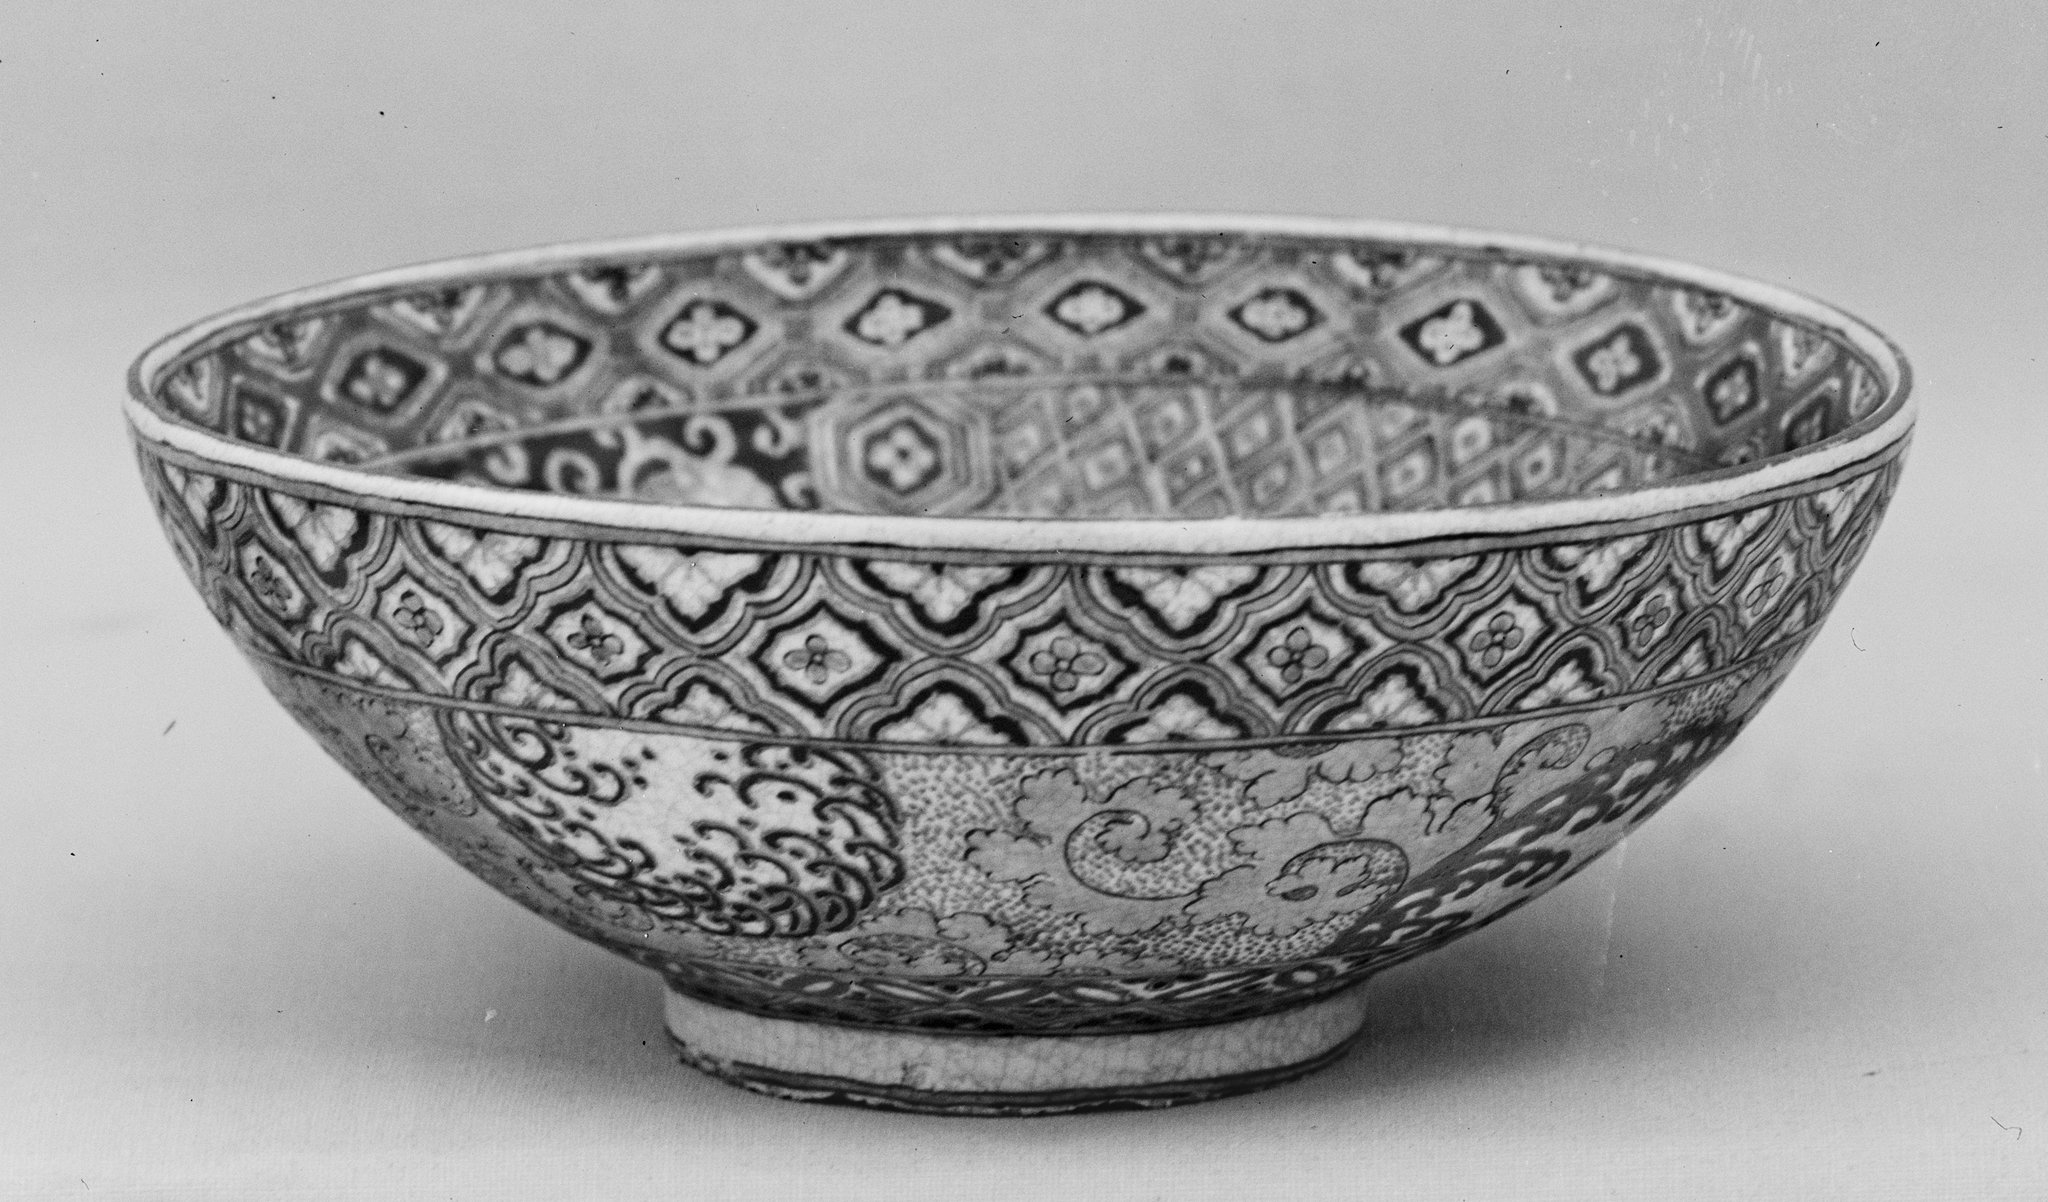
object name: bowl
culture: japanese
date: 1801-1866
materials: enamel, glaze, gold, pottery